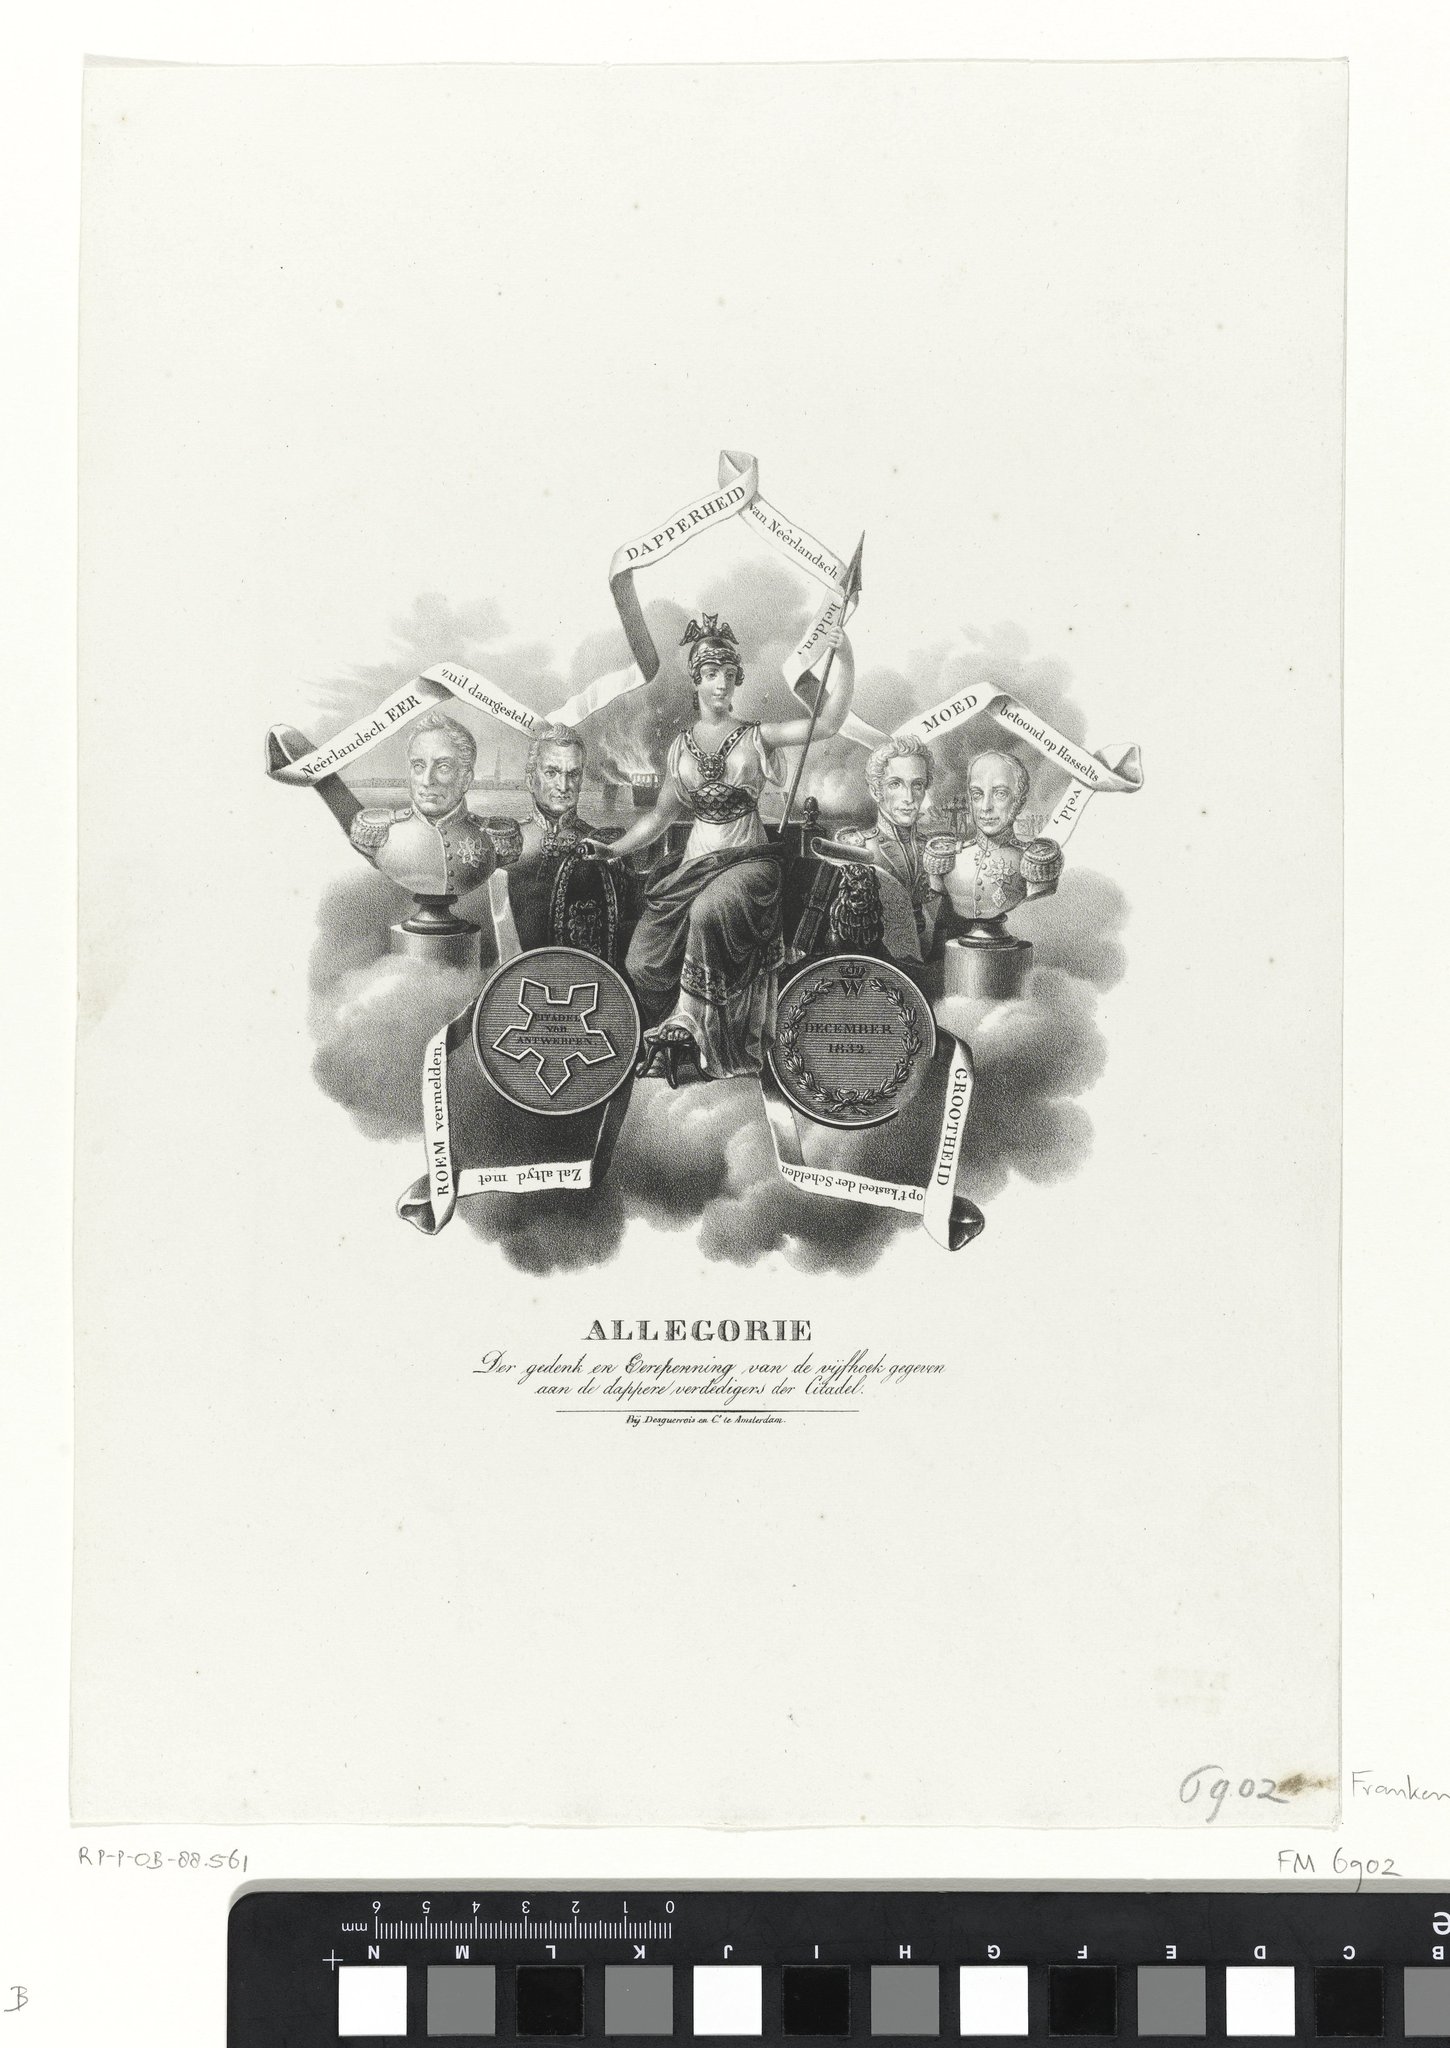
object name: print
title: Allegorie / Der gedenk en Eerepenning van de vijfhoek gegeven aan de dappere verdedigers der Citadel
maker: Anonymous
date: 1833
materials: paper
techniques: lithograph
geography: netherlands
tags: david hendrik baron chassé, the hague, berlin, william i of the netherlands, william ii of the netherlands, frederik (prins der nederlanden), personifications of countries, nations, states, districts, etc., defence of fortification or city, medals and other marks of military honour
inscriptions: collector's mark: Lugt 2165, collector's mark: Lugt 963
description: Allegorie op de Antwerpsche Medaille van 1832, toegekend aan de verdedigers van de Citadel van Antwerpen tijdens de belegering door het Franse leger in december 1832. Ingesteld per Koninklijk Besluit van 31 mei 1833. De Nederlandse Maagd in de wolken met portretbustes van koning Willem I, generaal Chassé, de prins van Oranje en prins Frederik. Op de achtergrond de brandende Citadel. Door de voorstelling linten met opschriften waardor deze de vorm heeft verkregen van een vijfhoek, gelijk het plan van de Citadel.